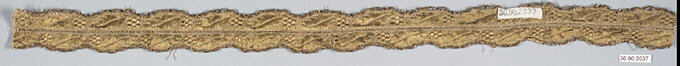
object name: galloon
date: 1767-1833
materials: silk